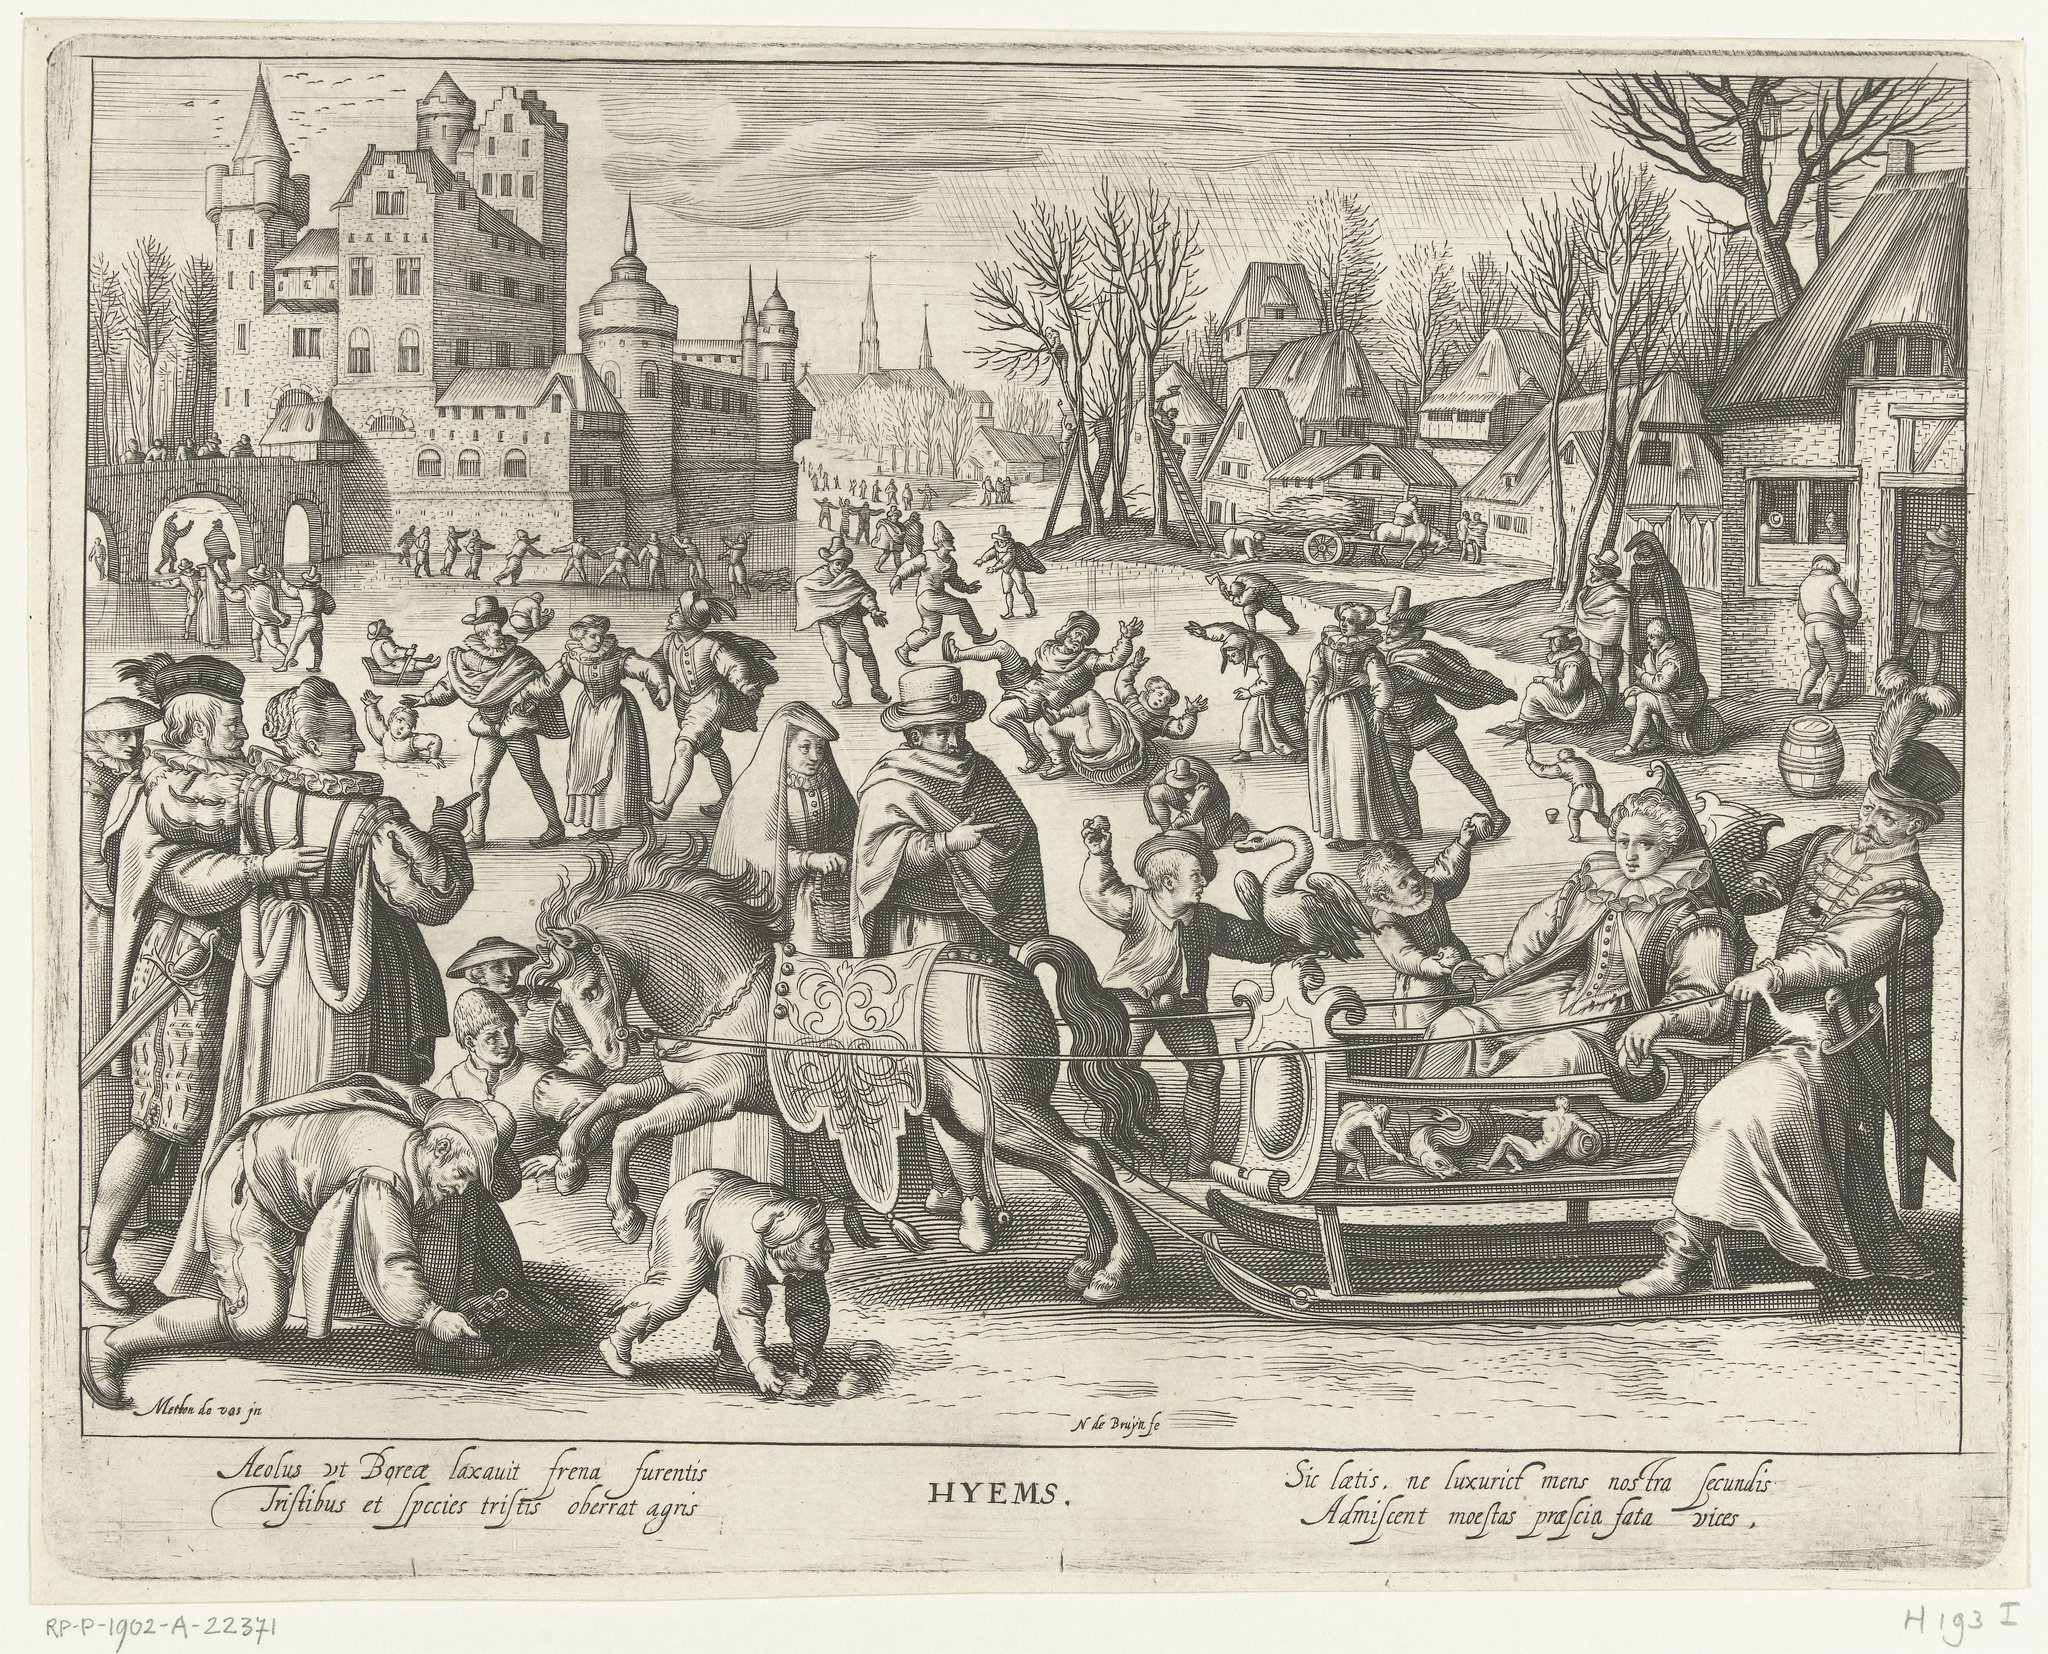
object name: print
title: Vier jaargetijden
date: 1581-1656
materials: paper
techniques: engraving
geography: netherlands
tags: winter ~ human activities (the four seasons of the year)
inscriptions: collector's mark: Lugt 2542, collector's mark: Lugt 2228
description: Winterlandschap met activiteiten die in dit seizoen plaatsvinden: mensen schaatsen op het ijs, een dame wordt in een slee vervoerd en kinderen gooien sneeuwballen. In de marge onder een vers in vier regels Latijn.